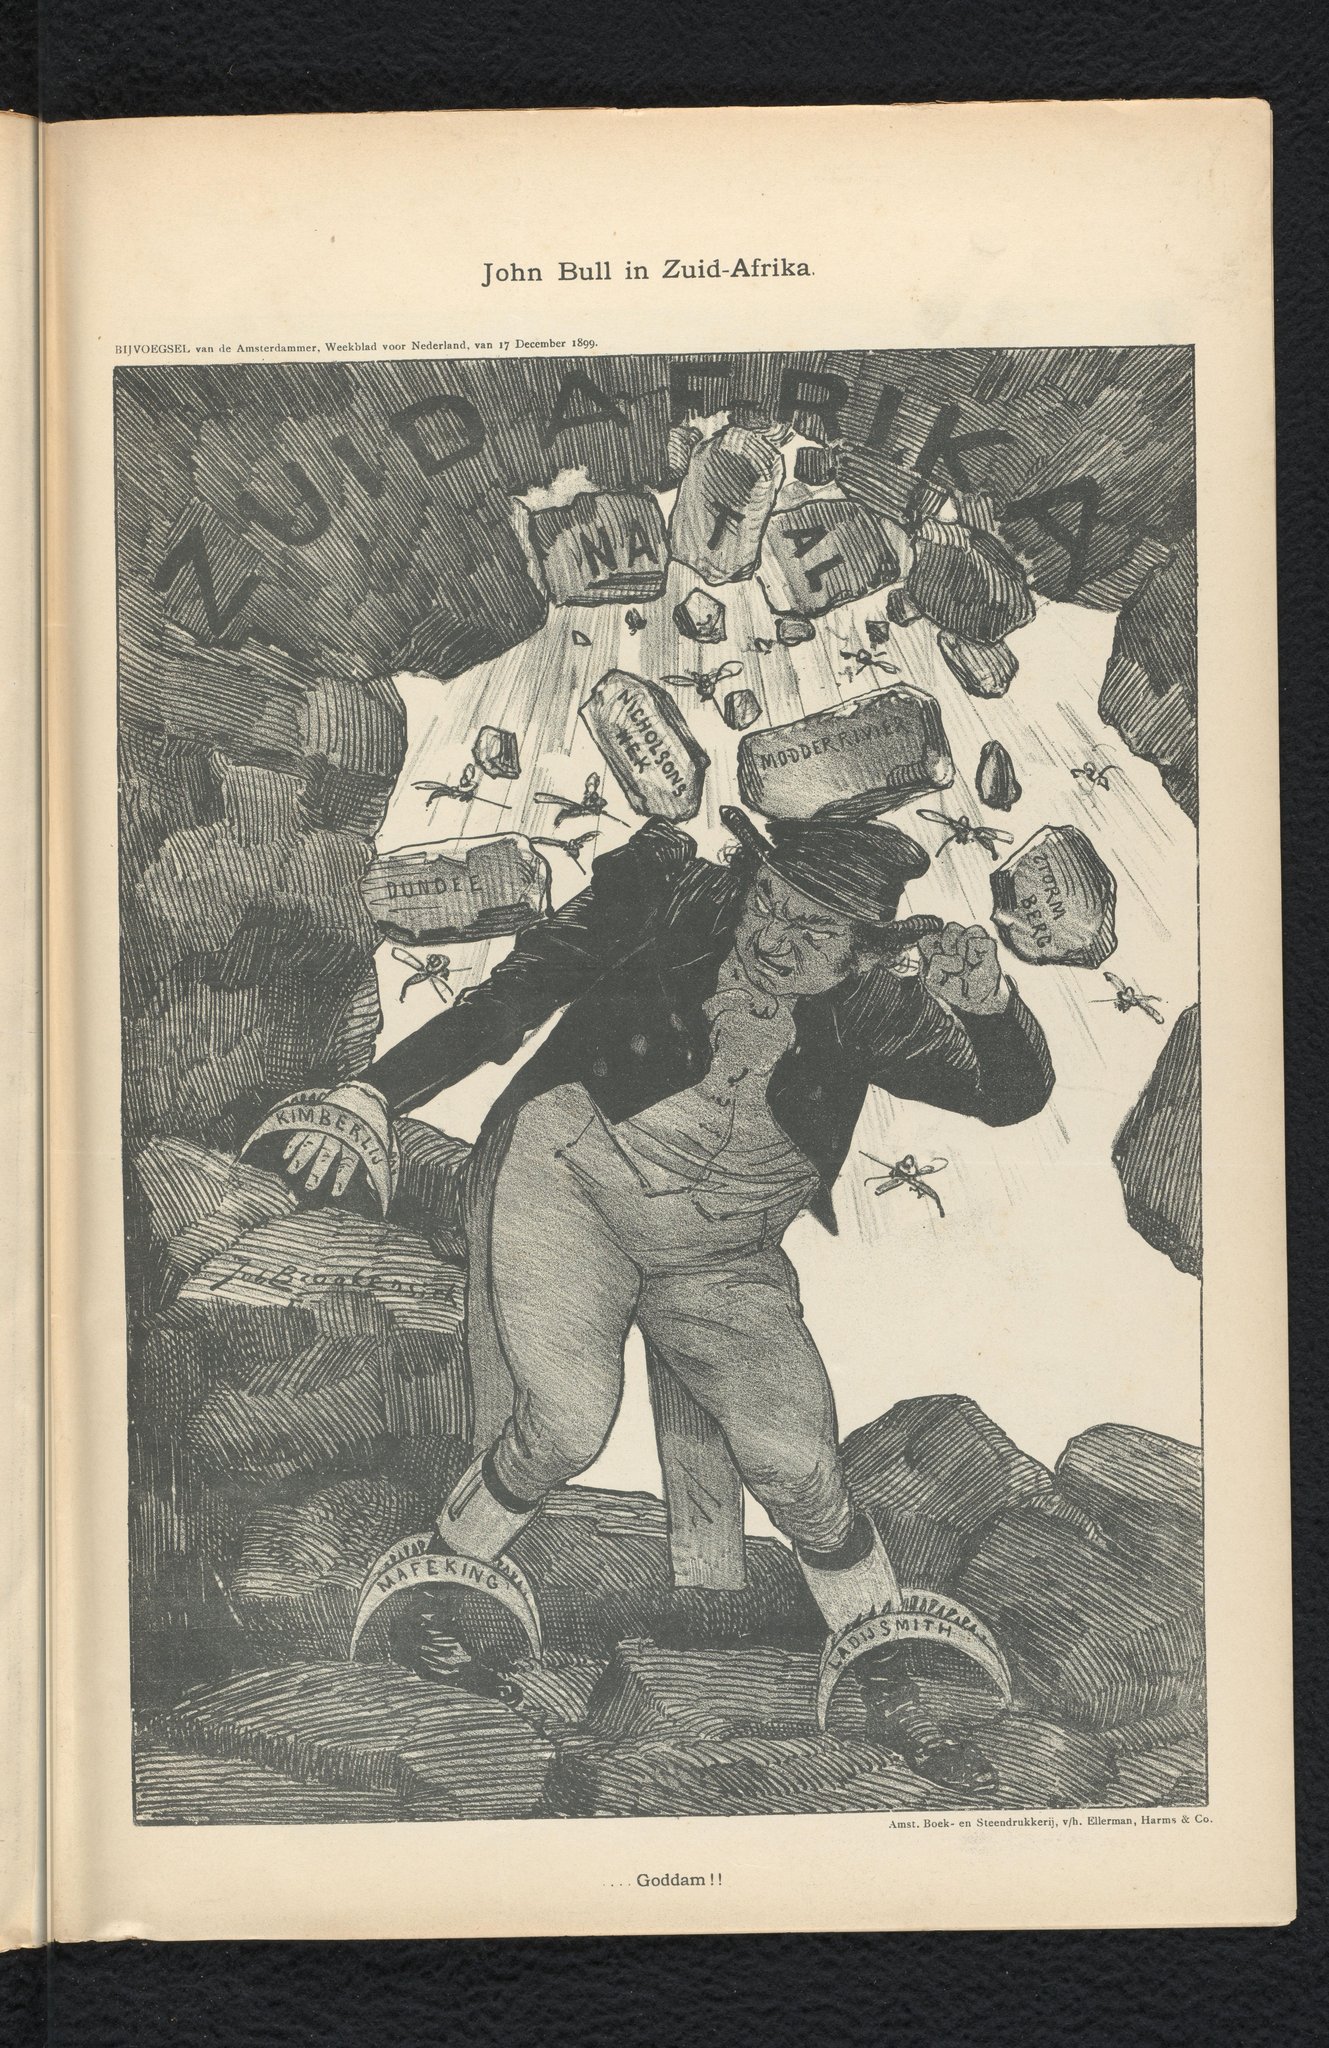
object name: cartoon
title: John Bull in Zuid-Afrika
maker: johan braakensiek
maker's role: draughtsman, print maker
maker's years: 1858-1940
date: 1899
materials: paper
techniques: lithograph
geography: amsterdam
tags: personifications of countries, nations, states, districts, etc., political caricatures and satires, insects: mosquito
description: John Bull (Engeland) wordt van alle kanten aangevallen als hij de grot Zuid-Afrika binnenloopt. Hij loopt in meerdere vallen tegelijk, krijgt stenen op zijn hoofd en wordt door muggen of steekvliegen aangevallen. Deze aanvallen verwijzen naar militaire nederlagen geleden door de Britse troepen in de oorlog.